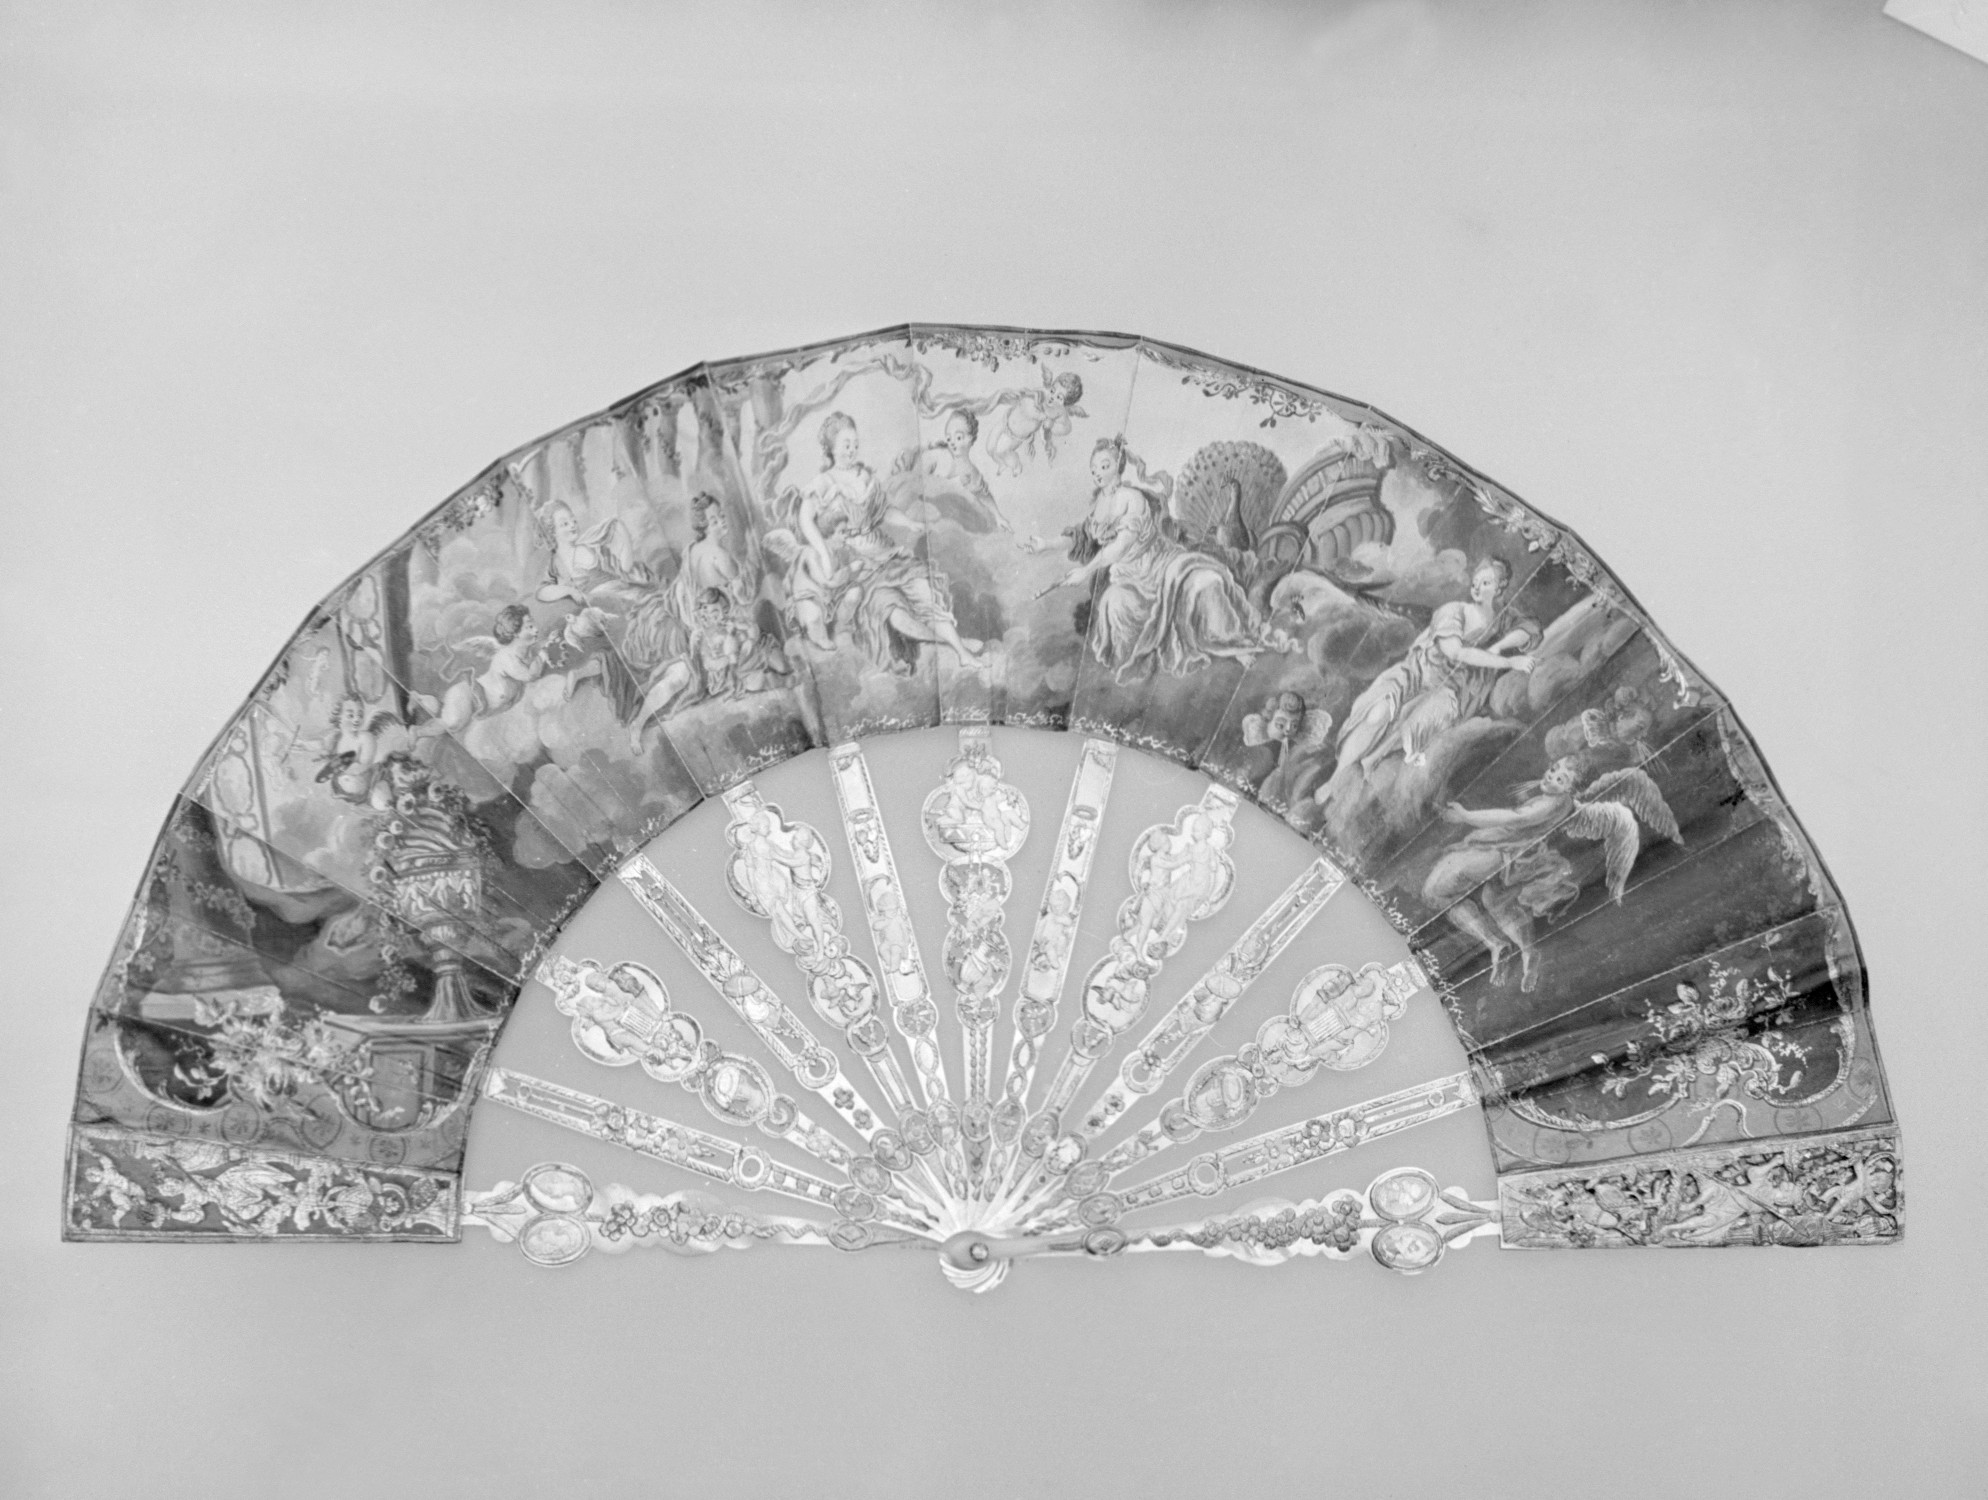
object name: fan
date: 1751-1775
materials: gold, mother of pearl, paper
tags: women,putti